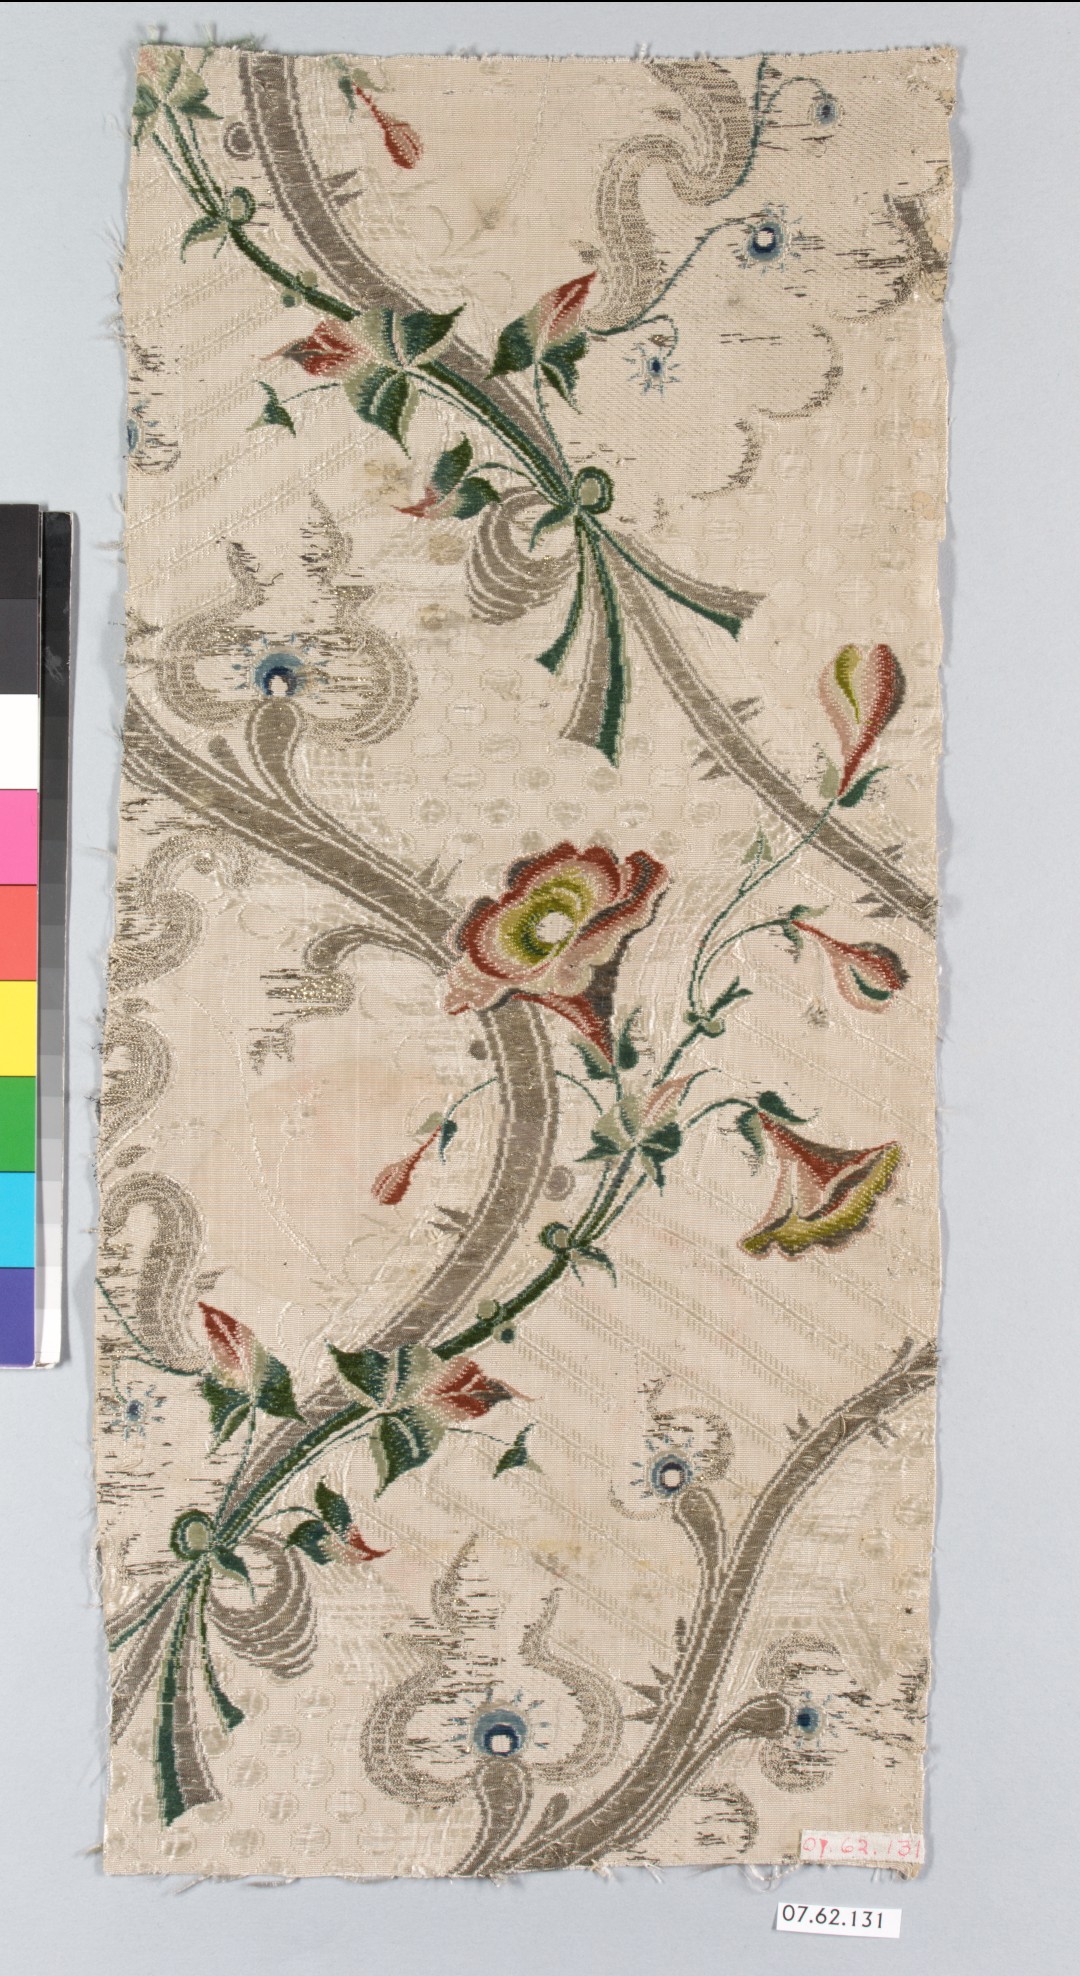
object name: piece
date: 1750-1760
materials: metal thread, silk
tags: flowers,leaves